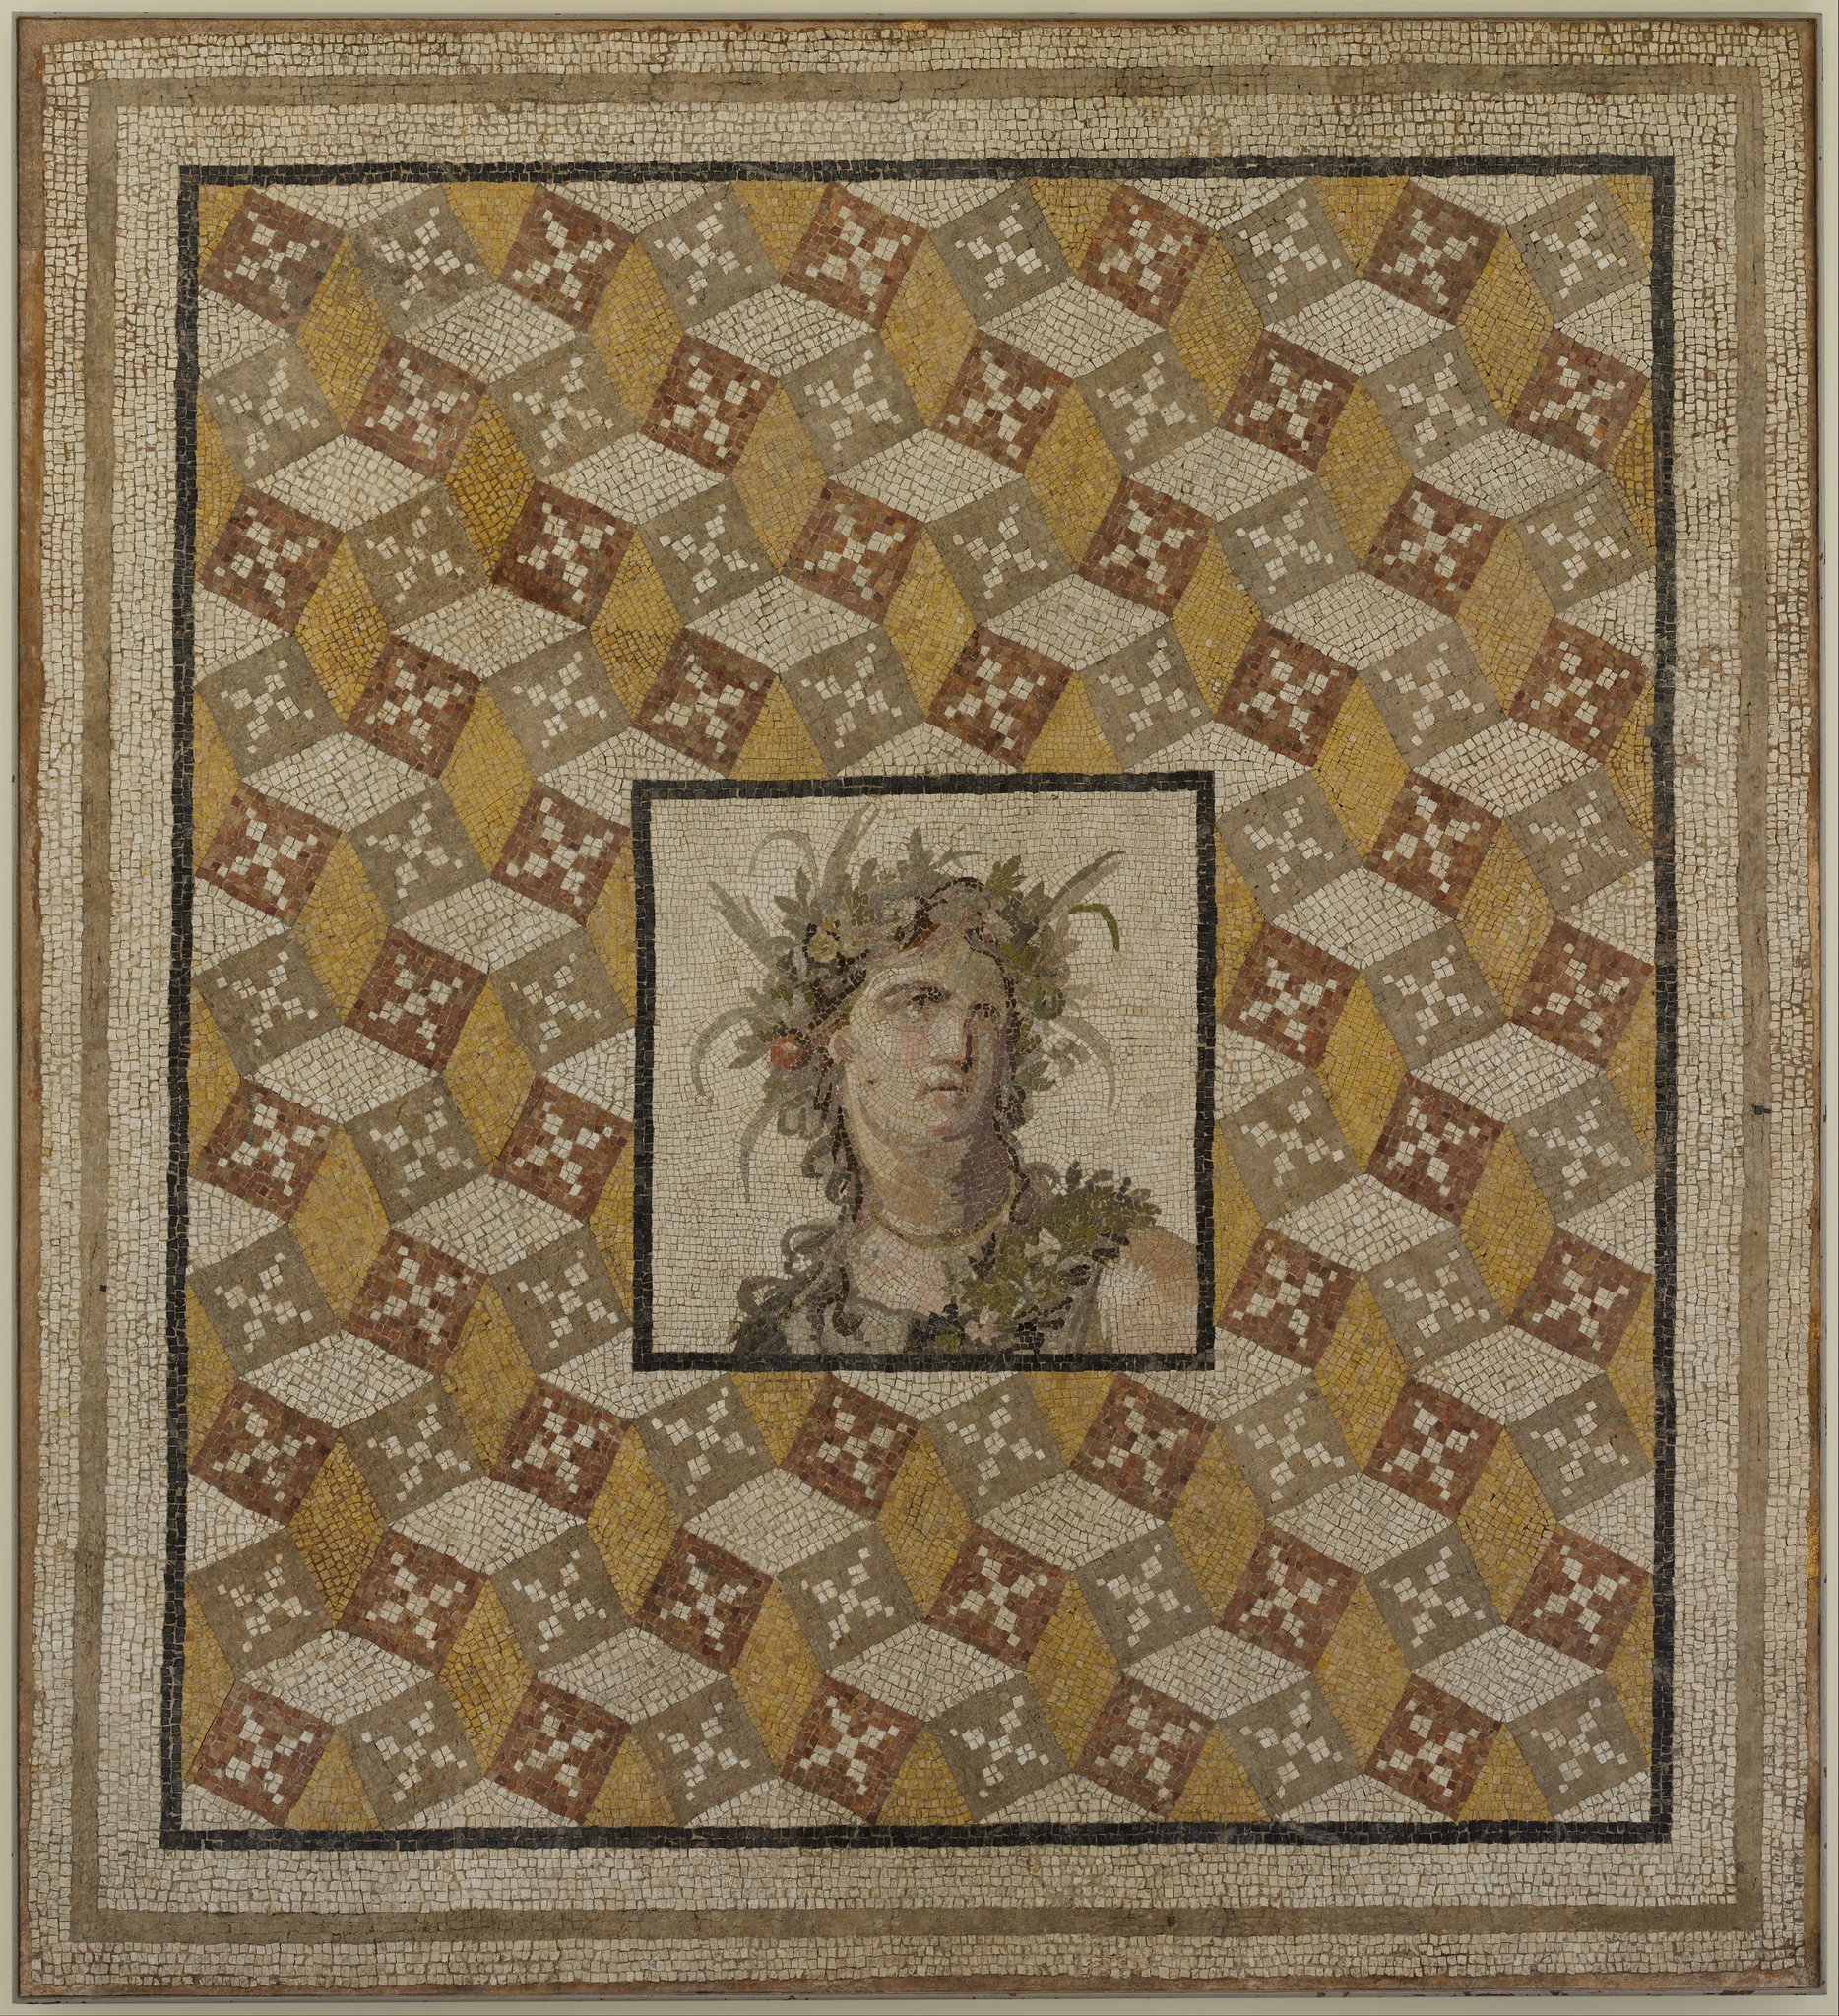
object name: mosaic floor with the head of spring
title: Mosaic floor panel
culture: roman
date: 101-200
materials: glass, stone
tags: garlands,women